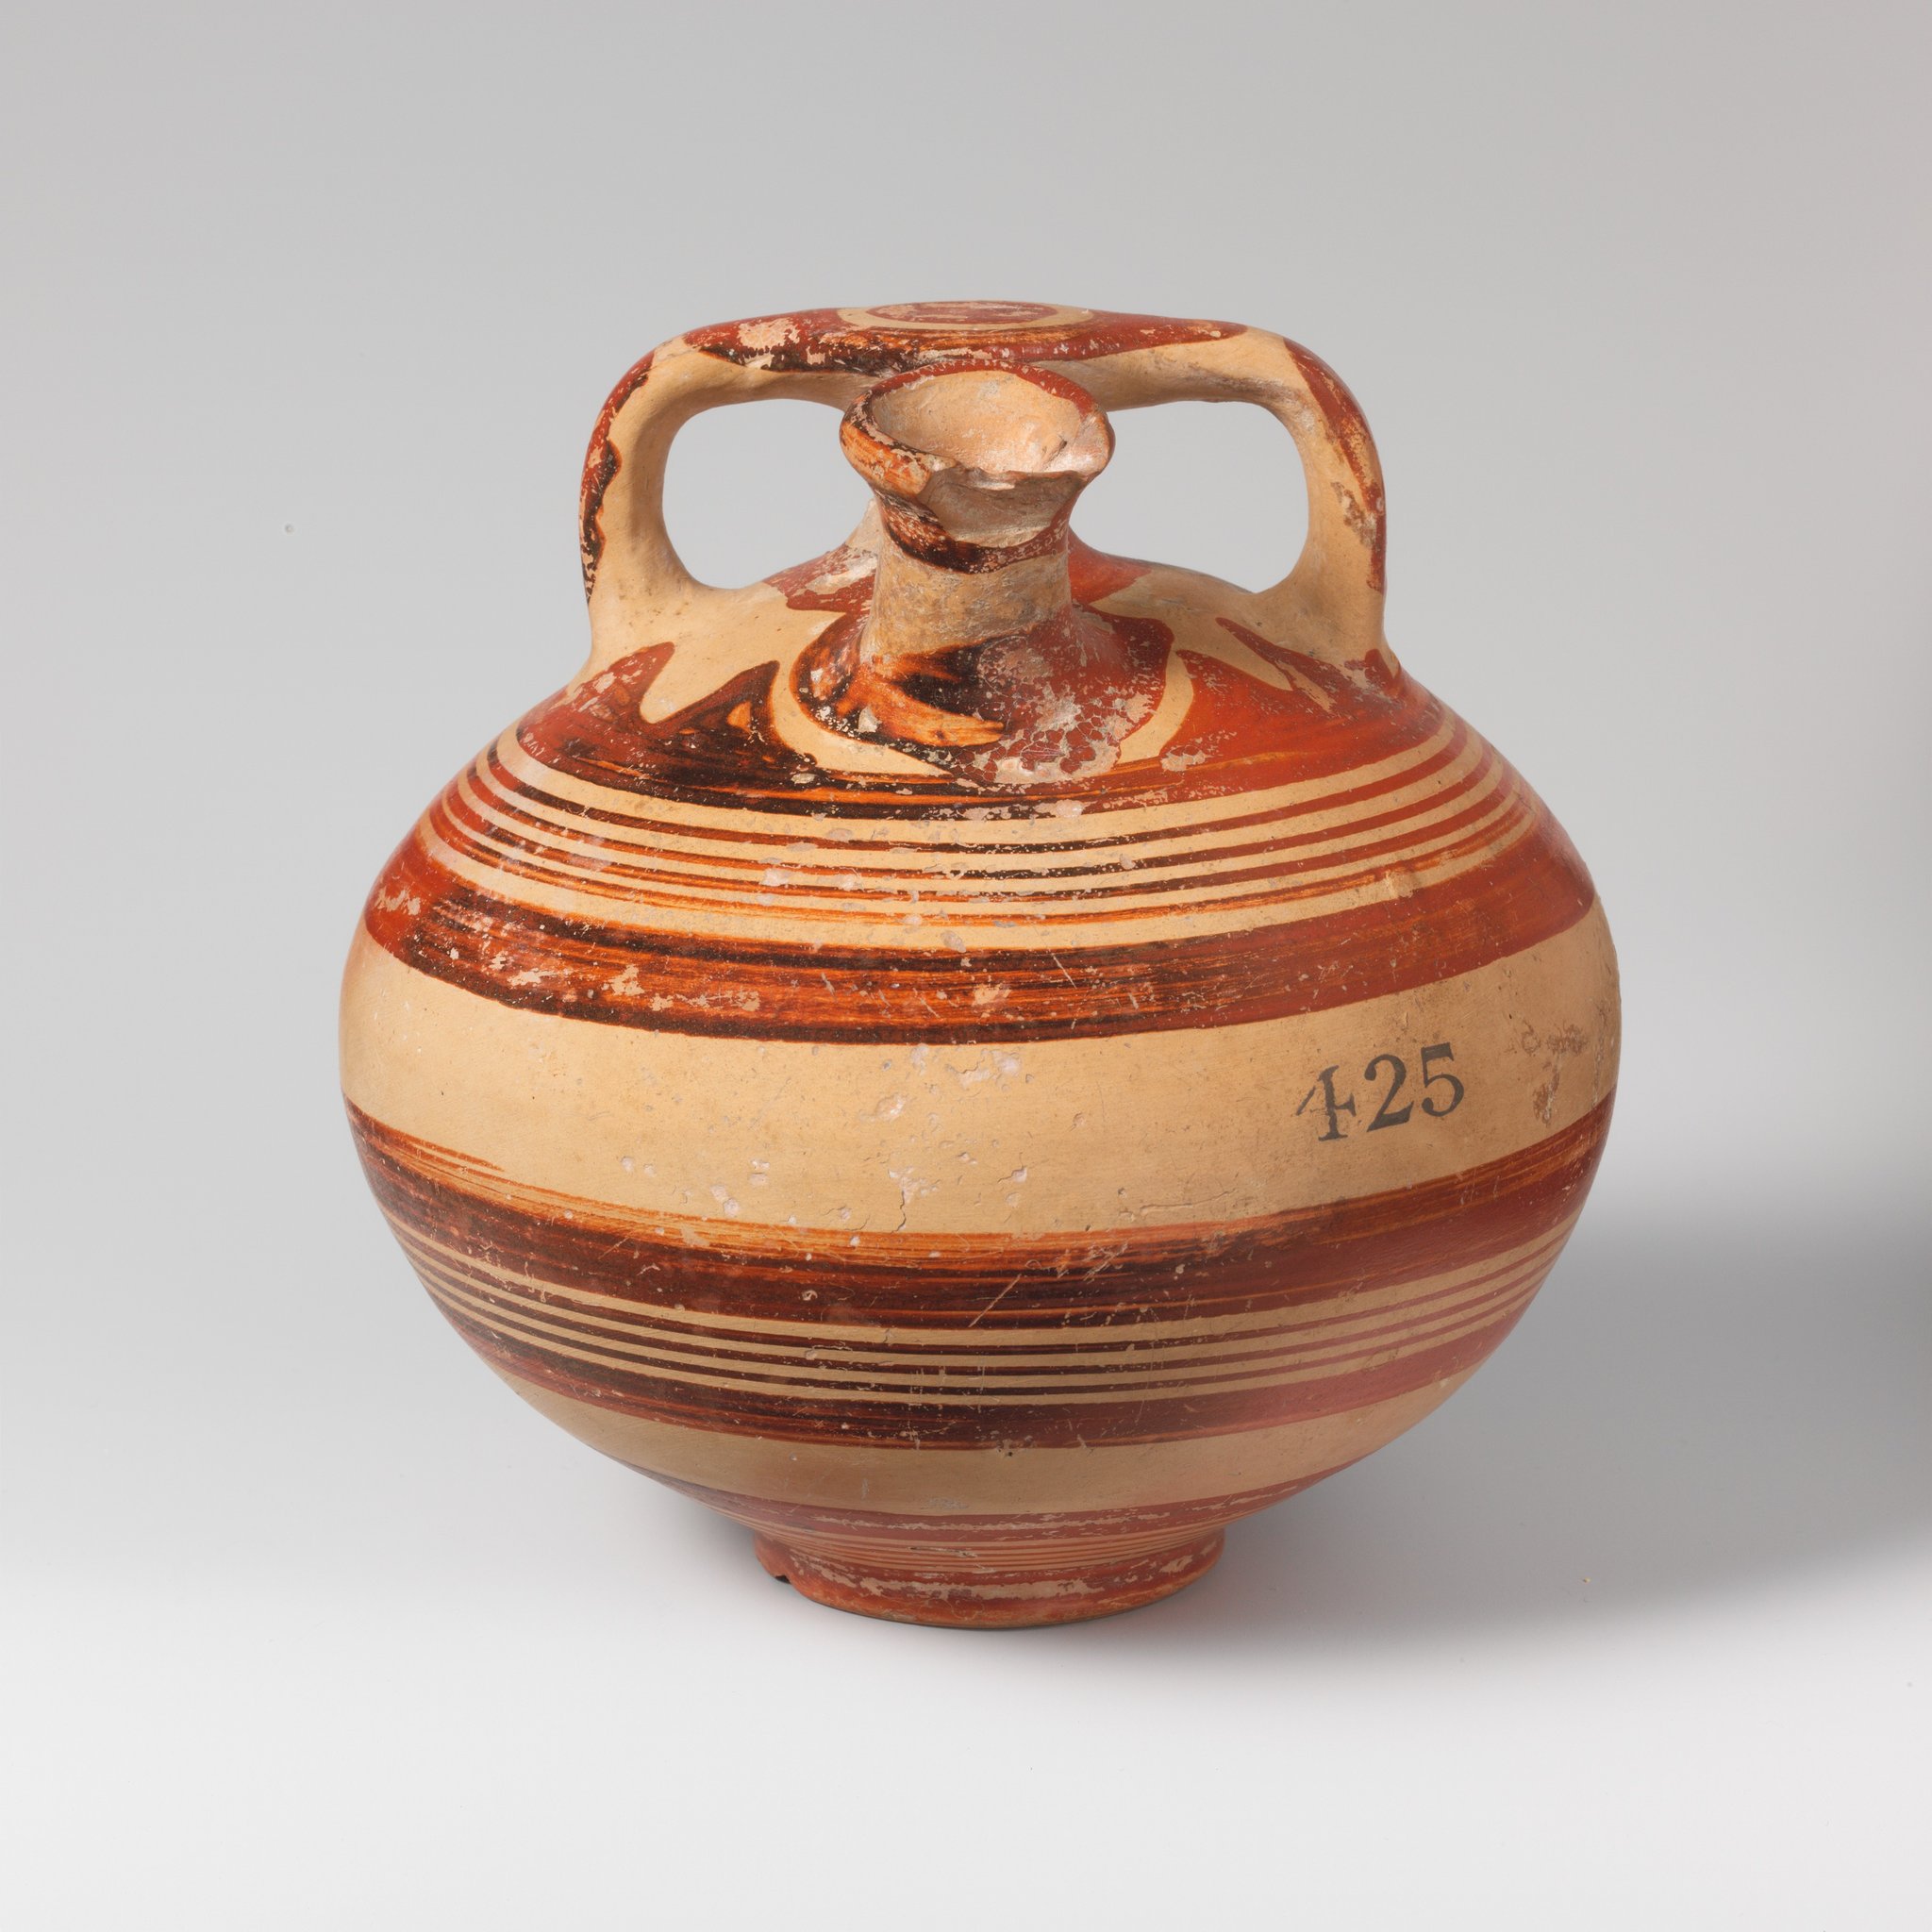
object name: false necked jar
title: Terracotta stirrup jar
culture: mycenaean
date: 1400-1050 BCE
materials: terracotta